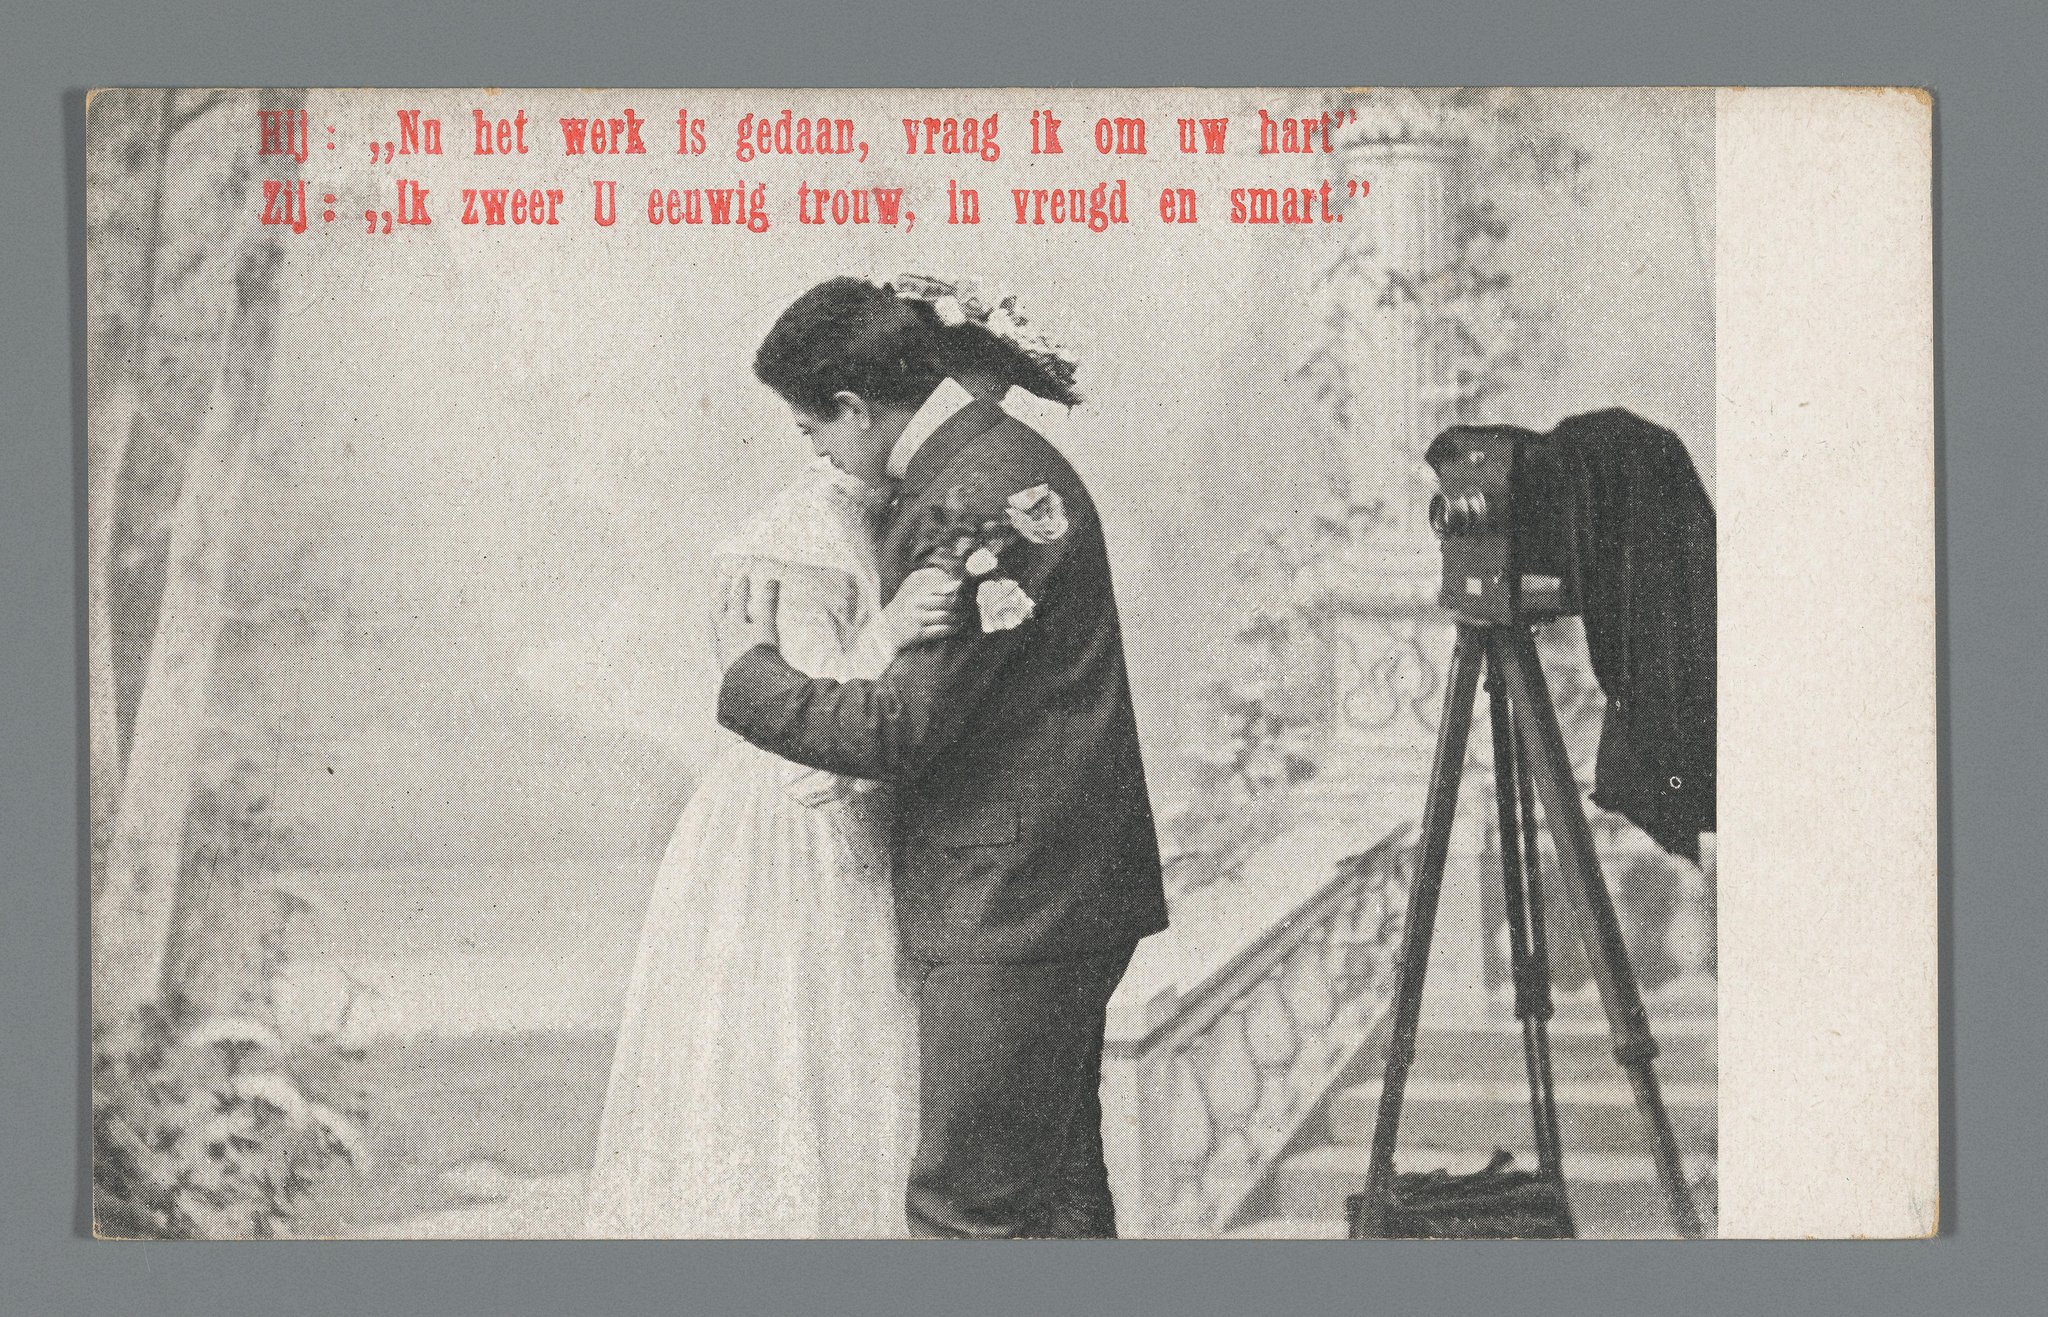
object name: ansichtkaart, prentbriefkaart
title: Man en vrouw houden elkaar vast voor een camera op statief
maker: Anonymous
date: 1892-1905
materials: cardboard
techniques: autotype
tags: camera ~ photography, (lovers) embracing each other, 'symplegma', historical persons not known by name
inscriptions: inscription: ‘Brefkort - Tarjetas postale/ Carte postale - Levelezö-lap - Cartolina postale/ Karta korespondencyjna - [...]/ Dopisnice - Postkarte - Briefkaart.’, inscription: ‘Hij: "Nu het werk is gedaan, vraag ik om uw hart"/ Zij: "Ik zweer u eeuwig trouw, in vreugd en smart."’, factory mark: ‘EXCELSIOR 87/7’, inscription: ‘6 stuks/ 7.00’